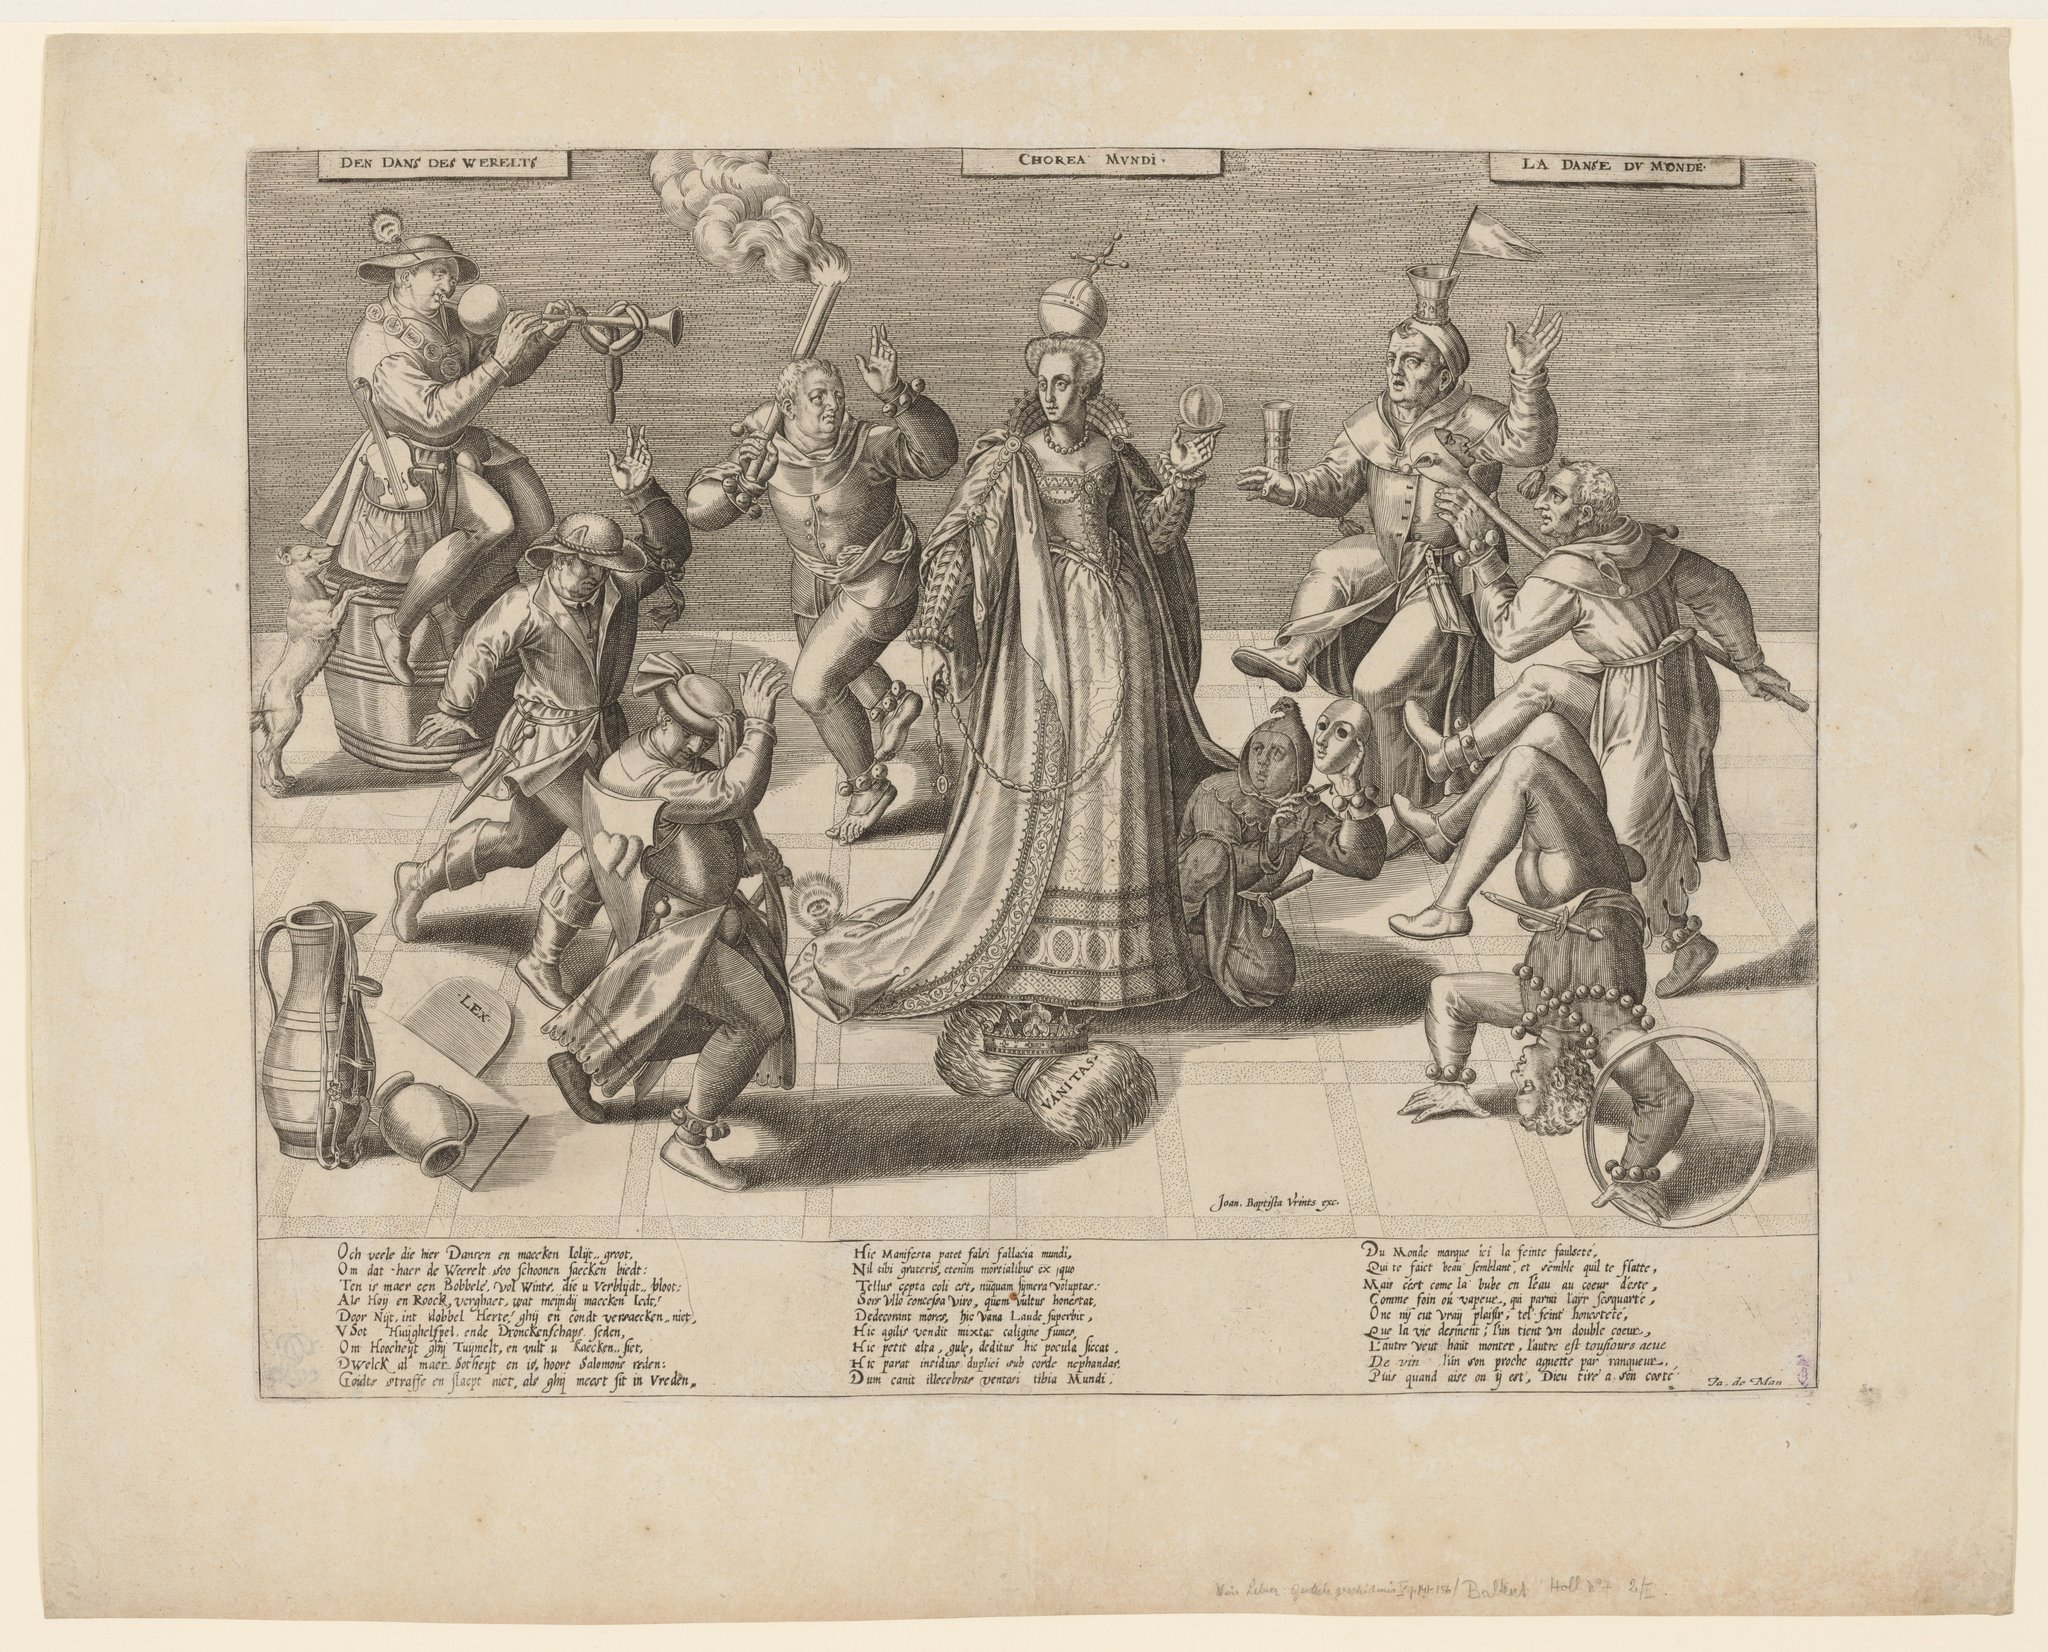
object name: print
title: The Dance of the World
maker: pieter baltens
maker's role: artist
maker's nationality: netherlandish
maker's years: 1526-1584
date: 1534-1566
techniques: engraving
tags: musical instruments,dance,men,women,dogs,dancers